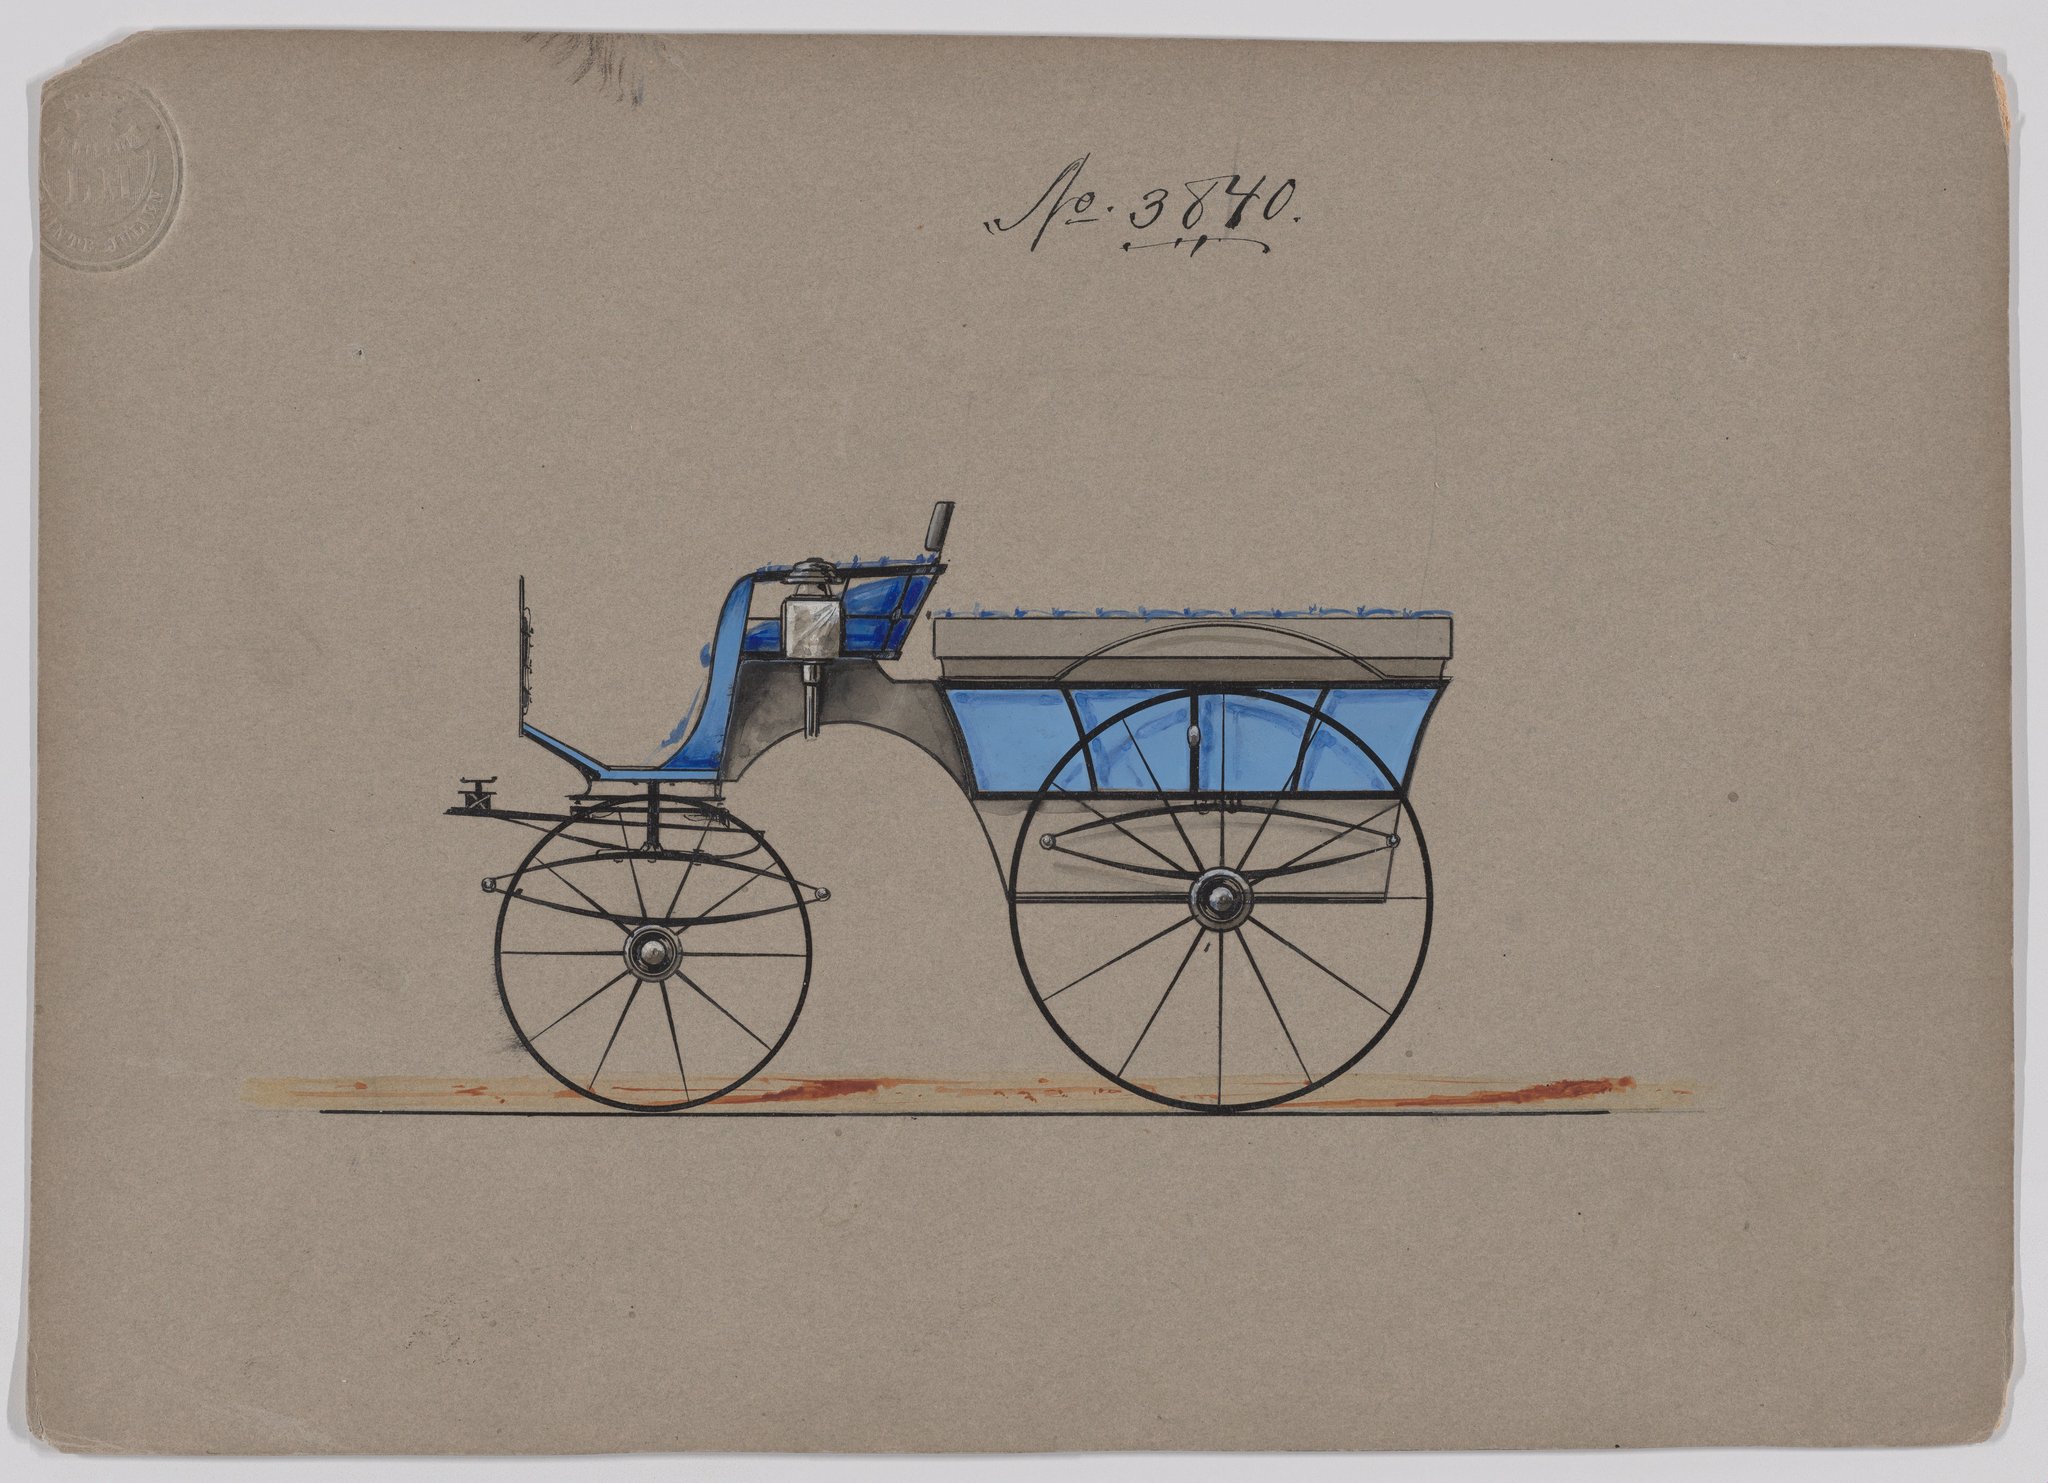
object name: drawing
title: Design for Omnibus or Wagonette, no. 3840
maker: brewster & co.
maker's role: manufacturer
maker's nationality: american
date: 1883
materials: gouache, gum arabic, ink, watercolor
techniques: pen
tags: carriages